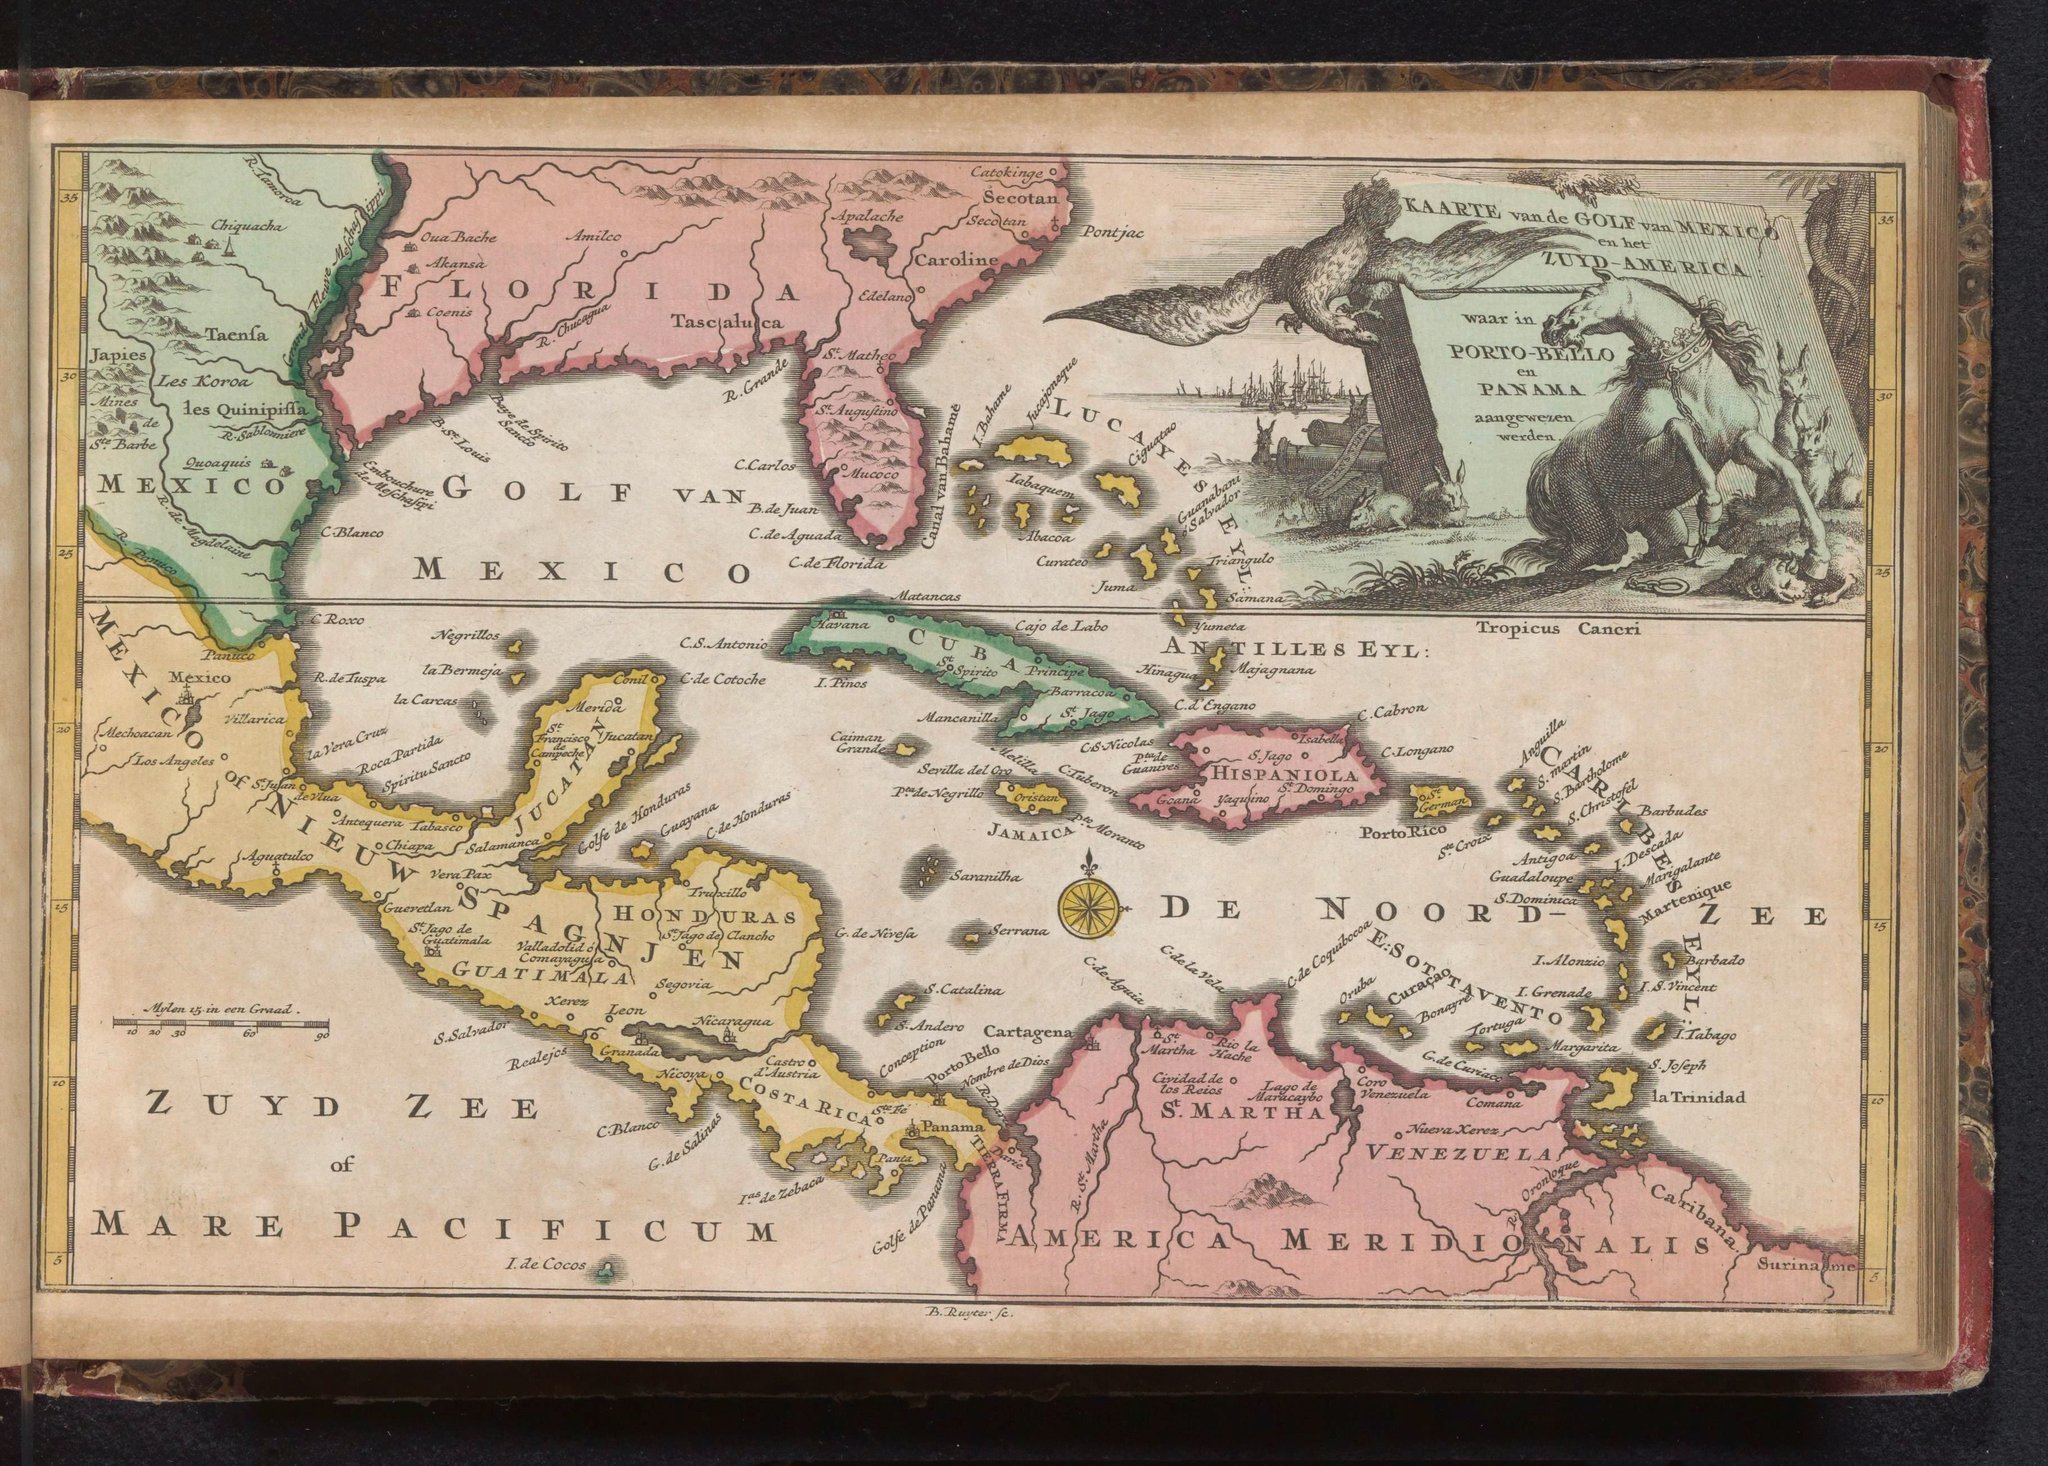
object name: print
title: Kaart van de Golf van Mexico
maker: balthasar ruyter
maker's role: print maker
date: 1735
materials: paper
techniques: engraving, etching, hand coloring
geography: amsterdam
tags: maps of separate countries or regions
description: Kaart van de landen gelegen aan de Golf van Mexico, rechtsboven een vignet met een (Engelse) eenhoorn die zijn ketting verbroken heeft en een ram onder een hoef houdt, in de lucht een adelaar. Hierbij ook enkele konijnen. Waarschijnlijk in verband met het strijdtoneel van de Spaanse Successieoorlog. Onderdeel van een atlas met 223 kaarten van landen en steden en oorlogstaferelen in Europa in de periode ca. 1690-1735.